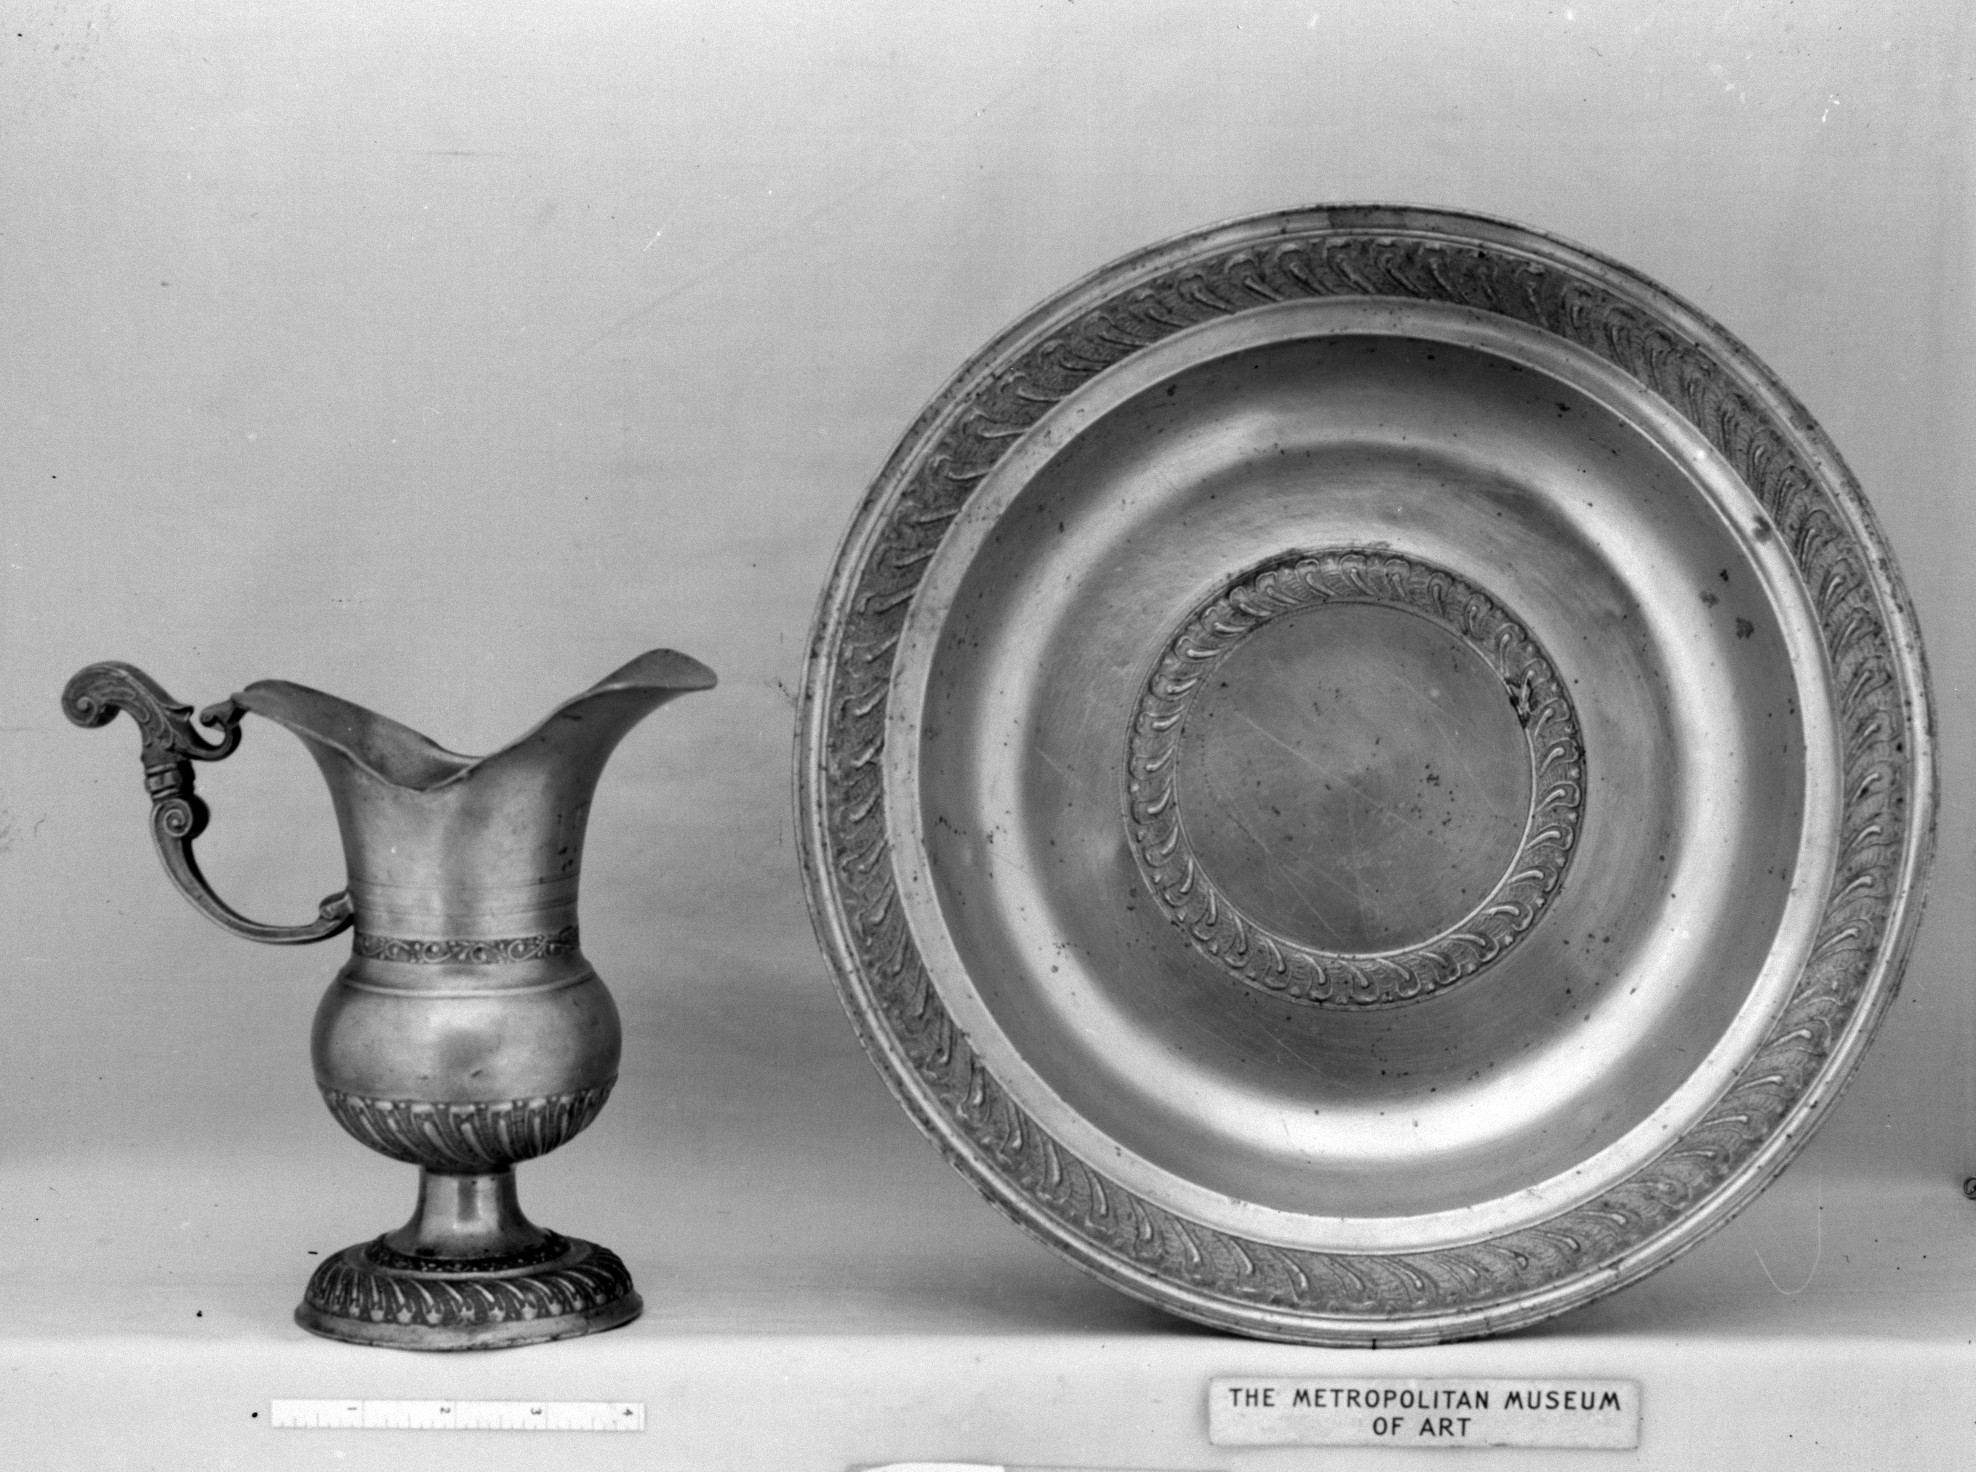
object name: basin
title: Basin (part of a set)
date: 1801-1900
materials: pewter